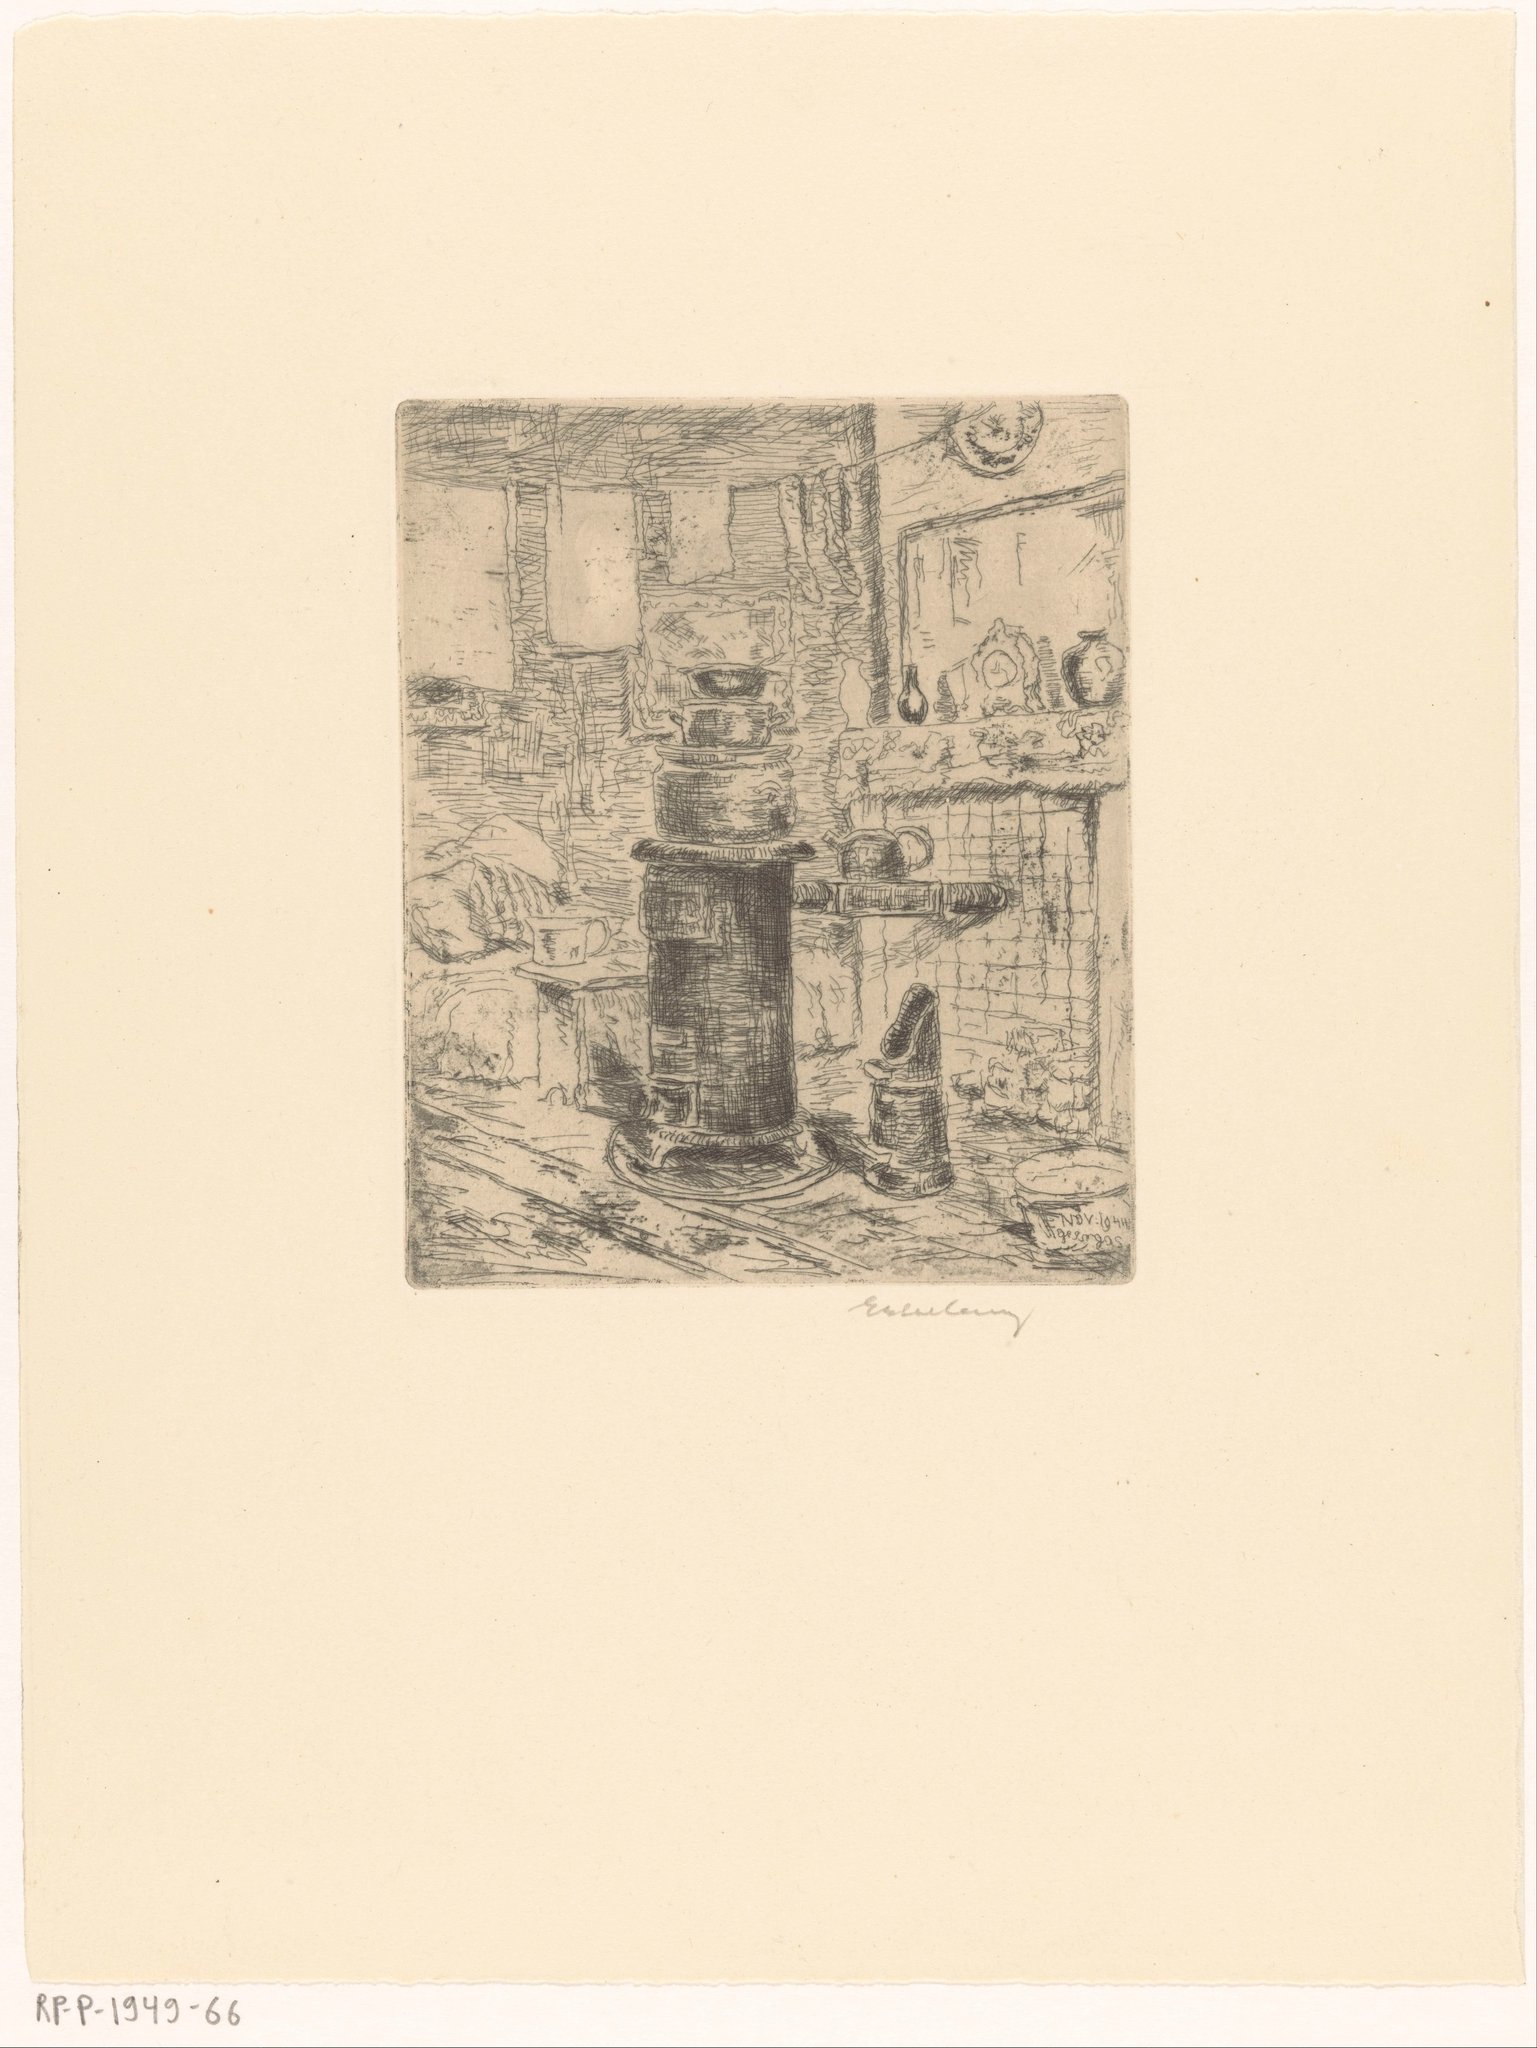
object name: print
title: Geen gas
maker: erkelens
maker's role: print maker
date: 1911-1944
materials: paper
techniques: etching, intaglio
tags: interior of the house, heating stove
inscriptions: collector's mark: Lugt 2228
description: Een interieur met een stapel pannen op een kolenkachel. Boven de kachel hangt er kleding aan een waslijn. Op de schoorsteenmantel staan drie vazen en een klok. Links op de achtergrond een bed.